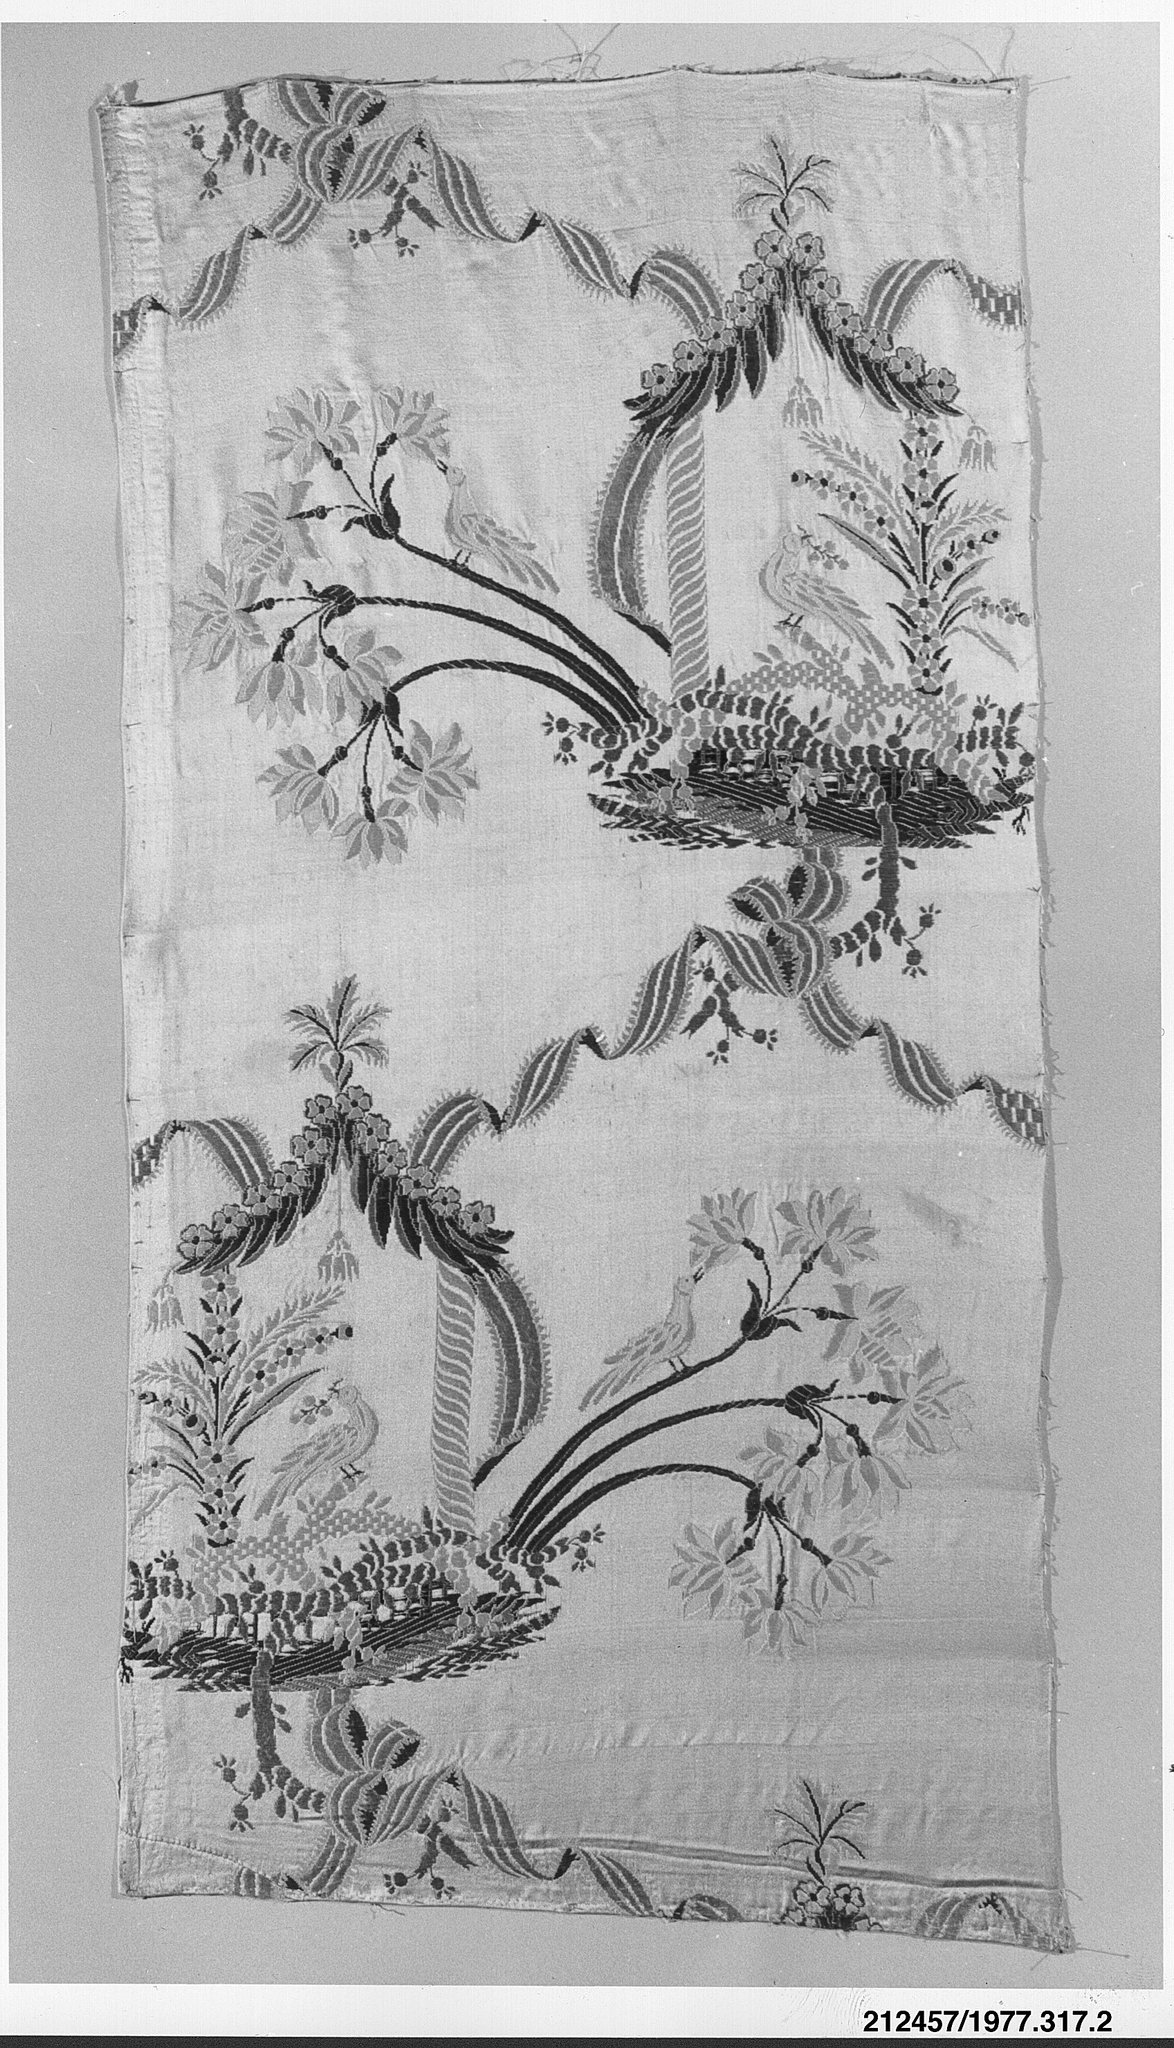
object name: length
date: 1830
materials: silk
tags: birds,flowers